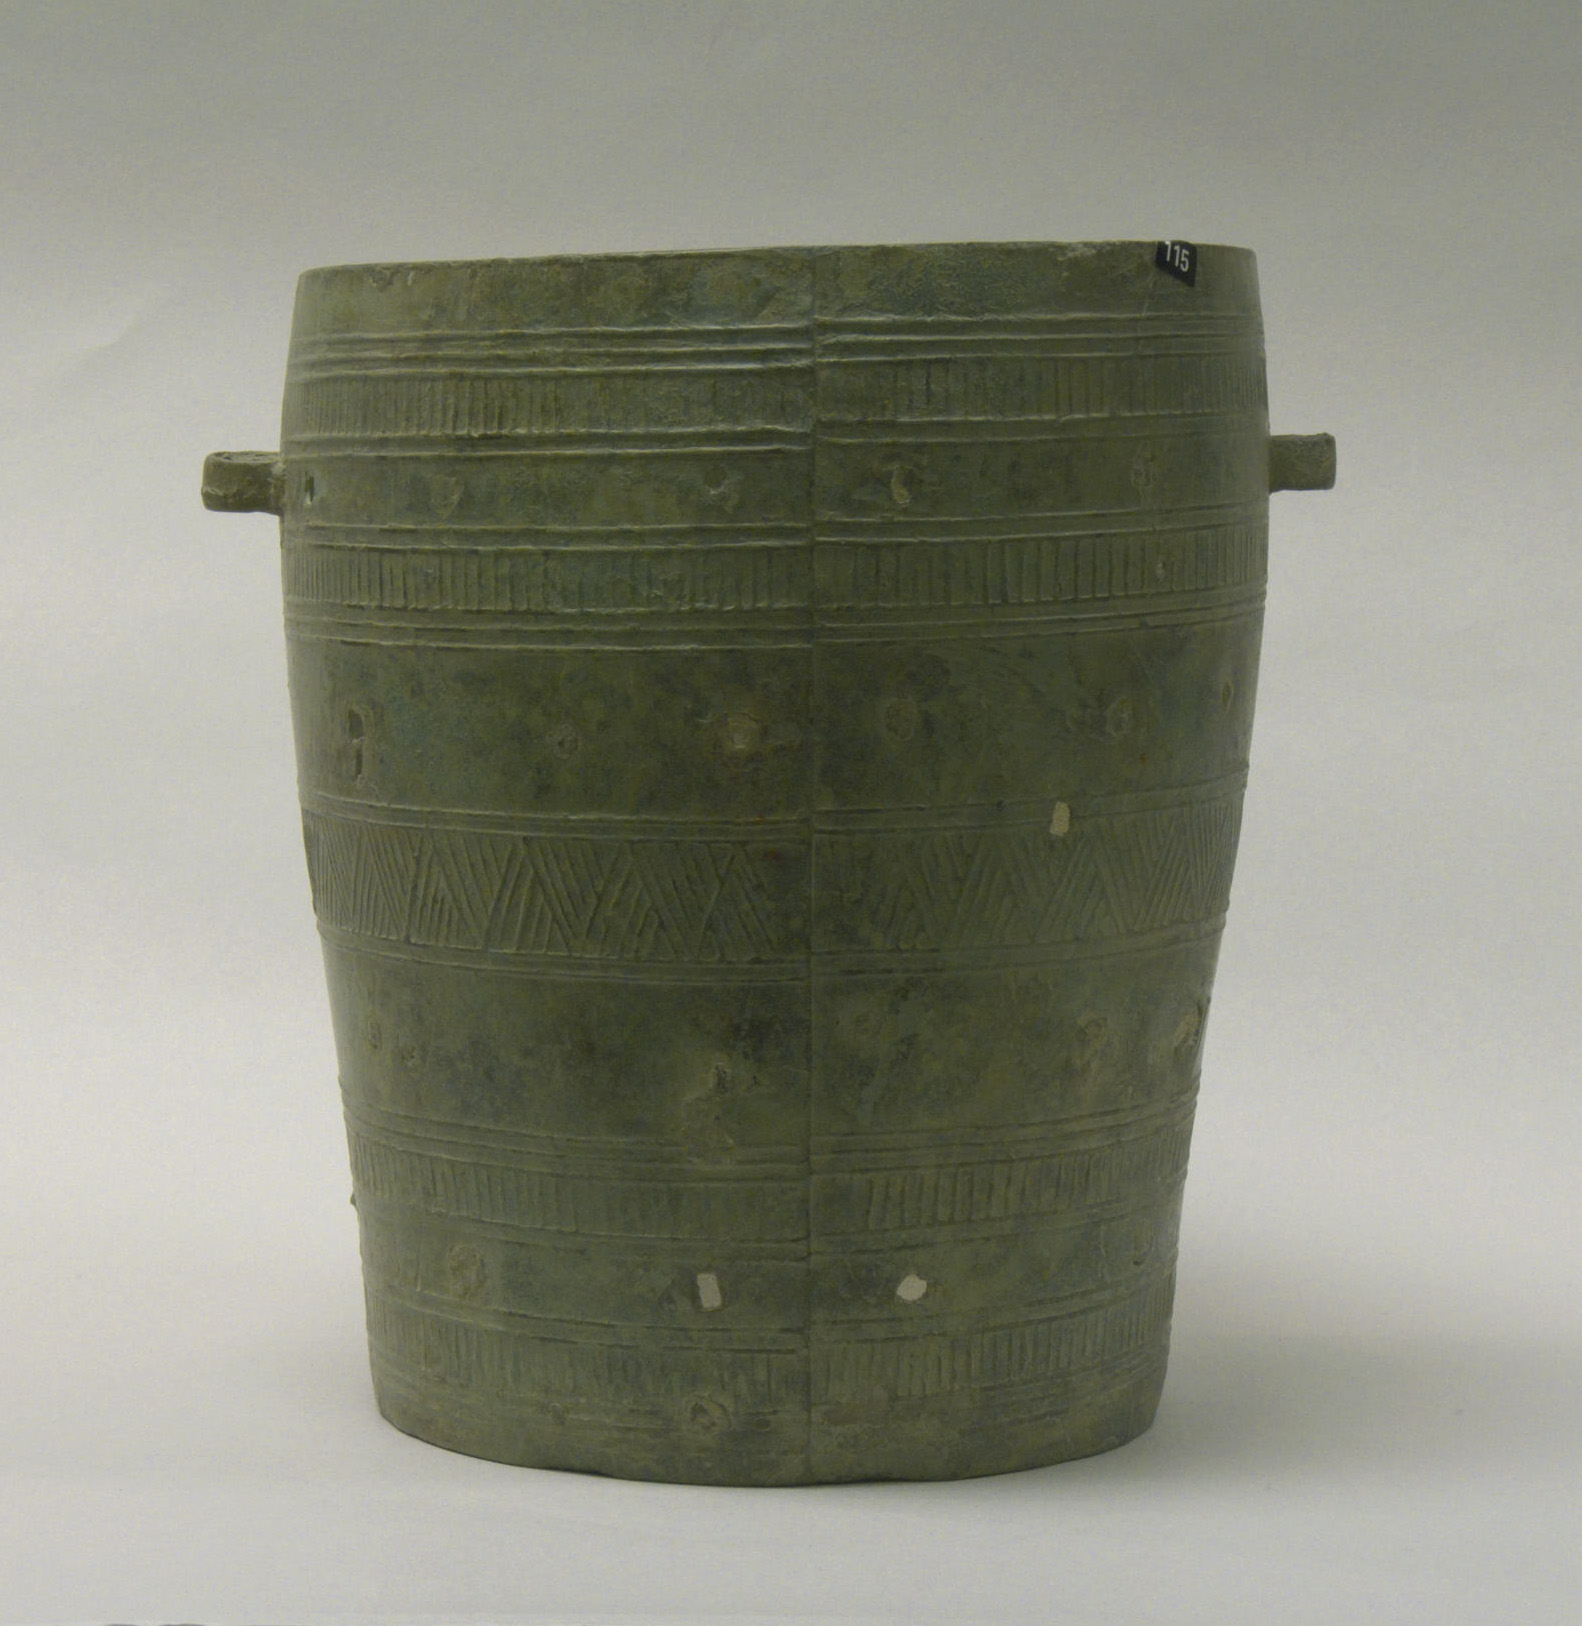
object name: situla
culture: vietnamese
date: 500 BCE-300 CE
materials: bronze